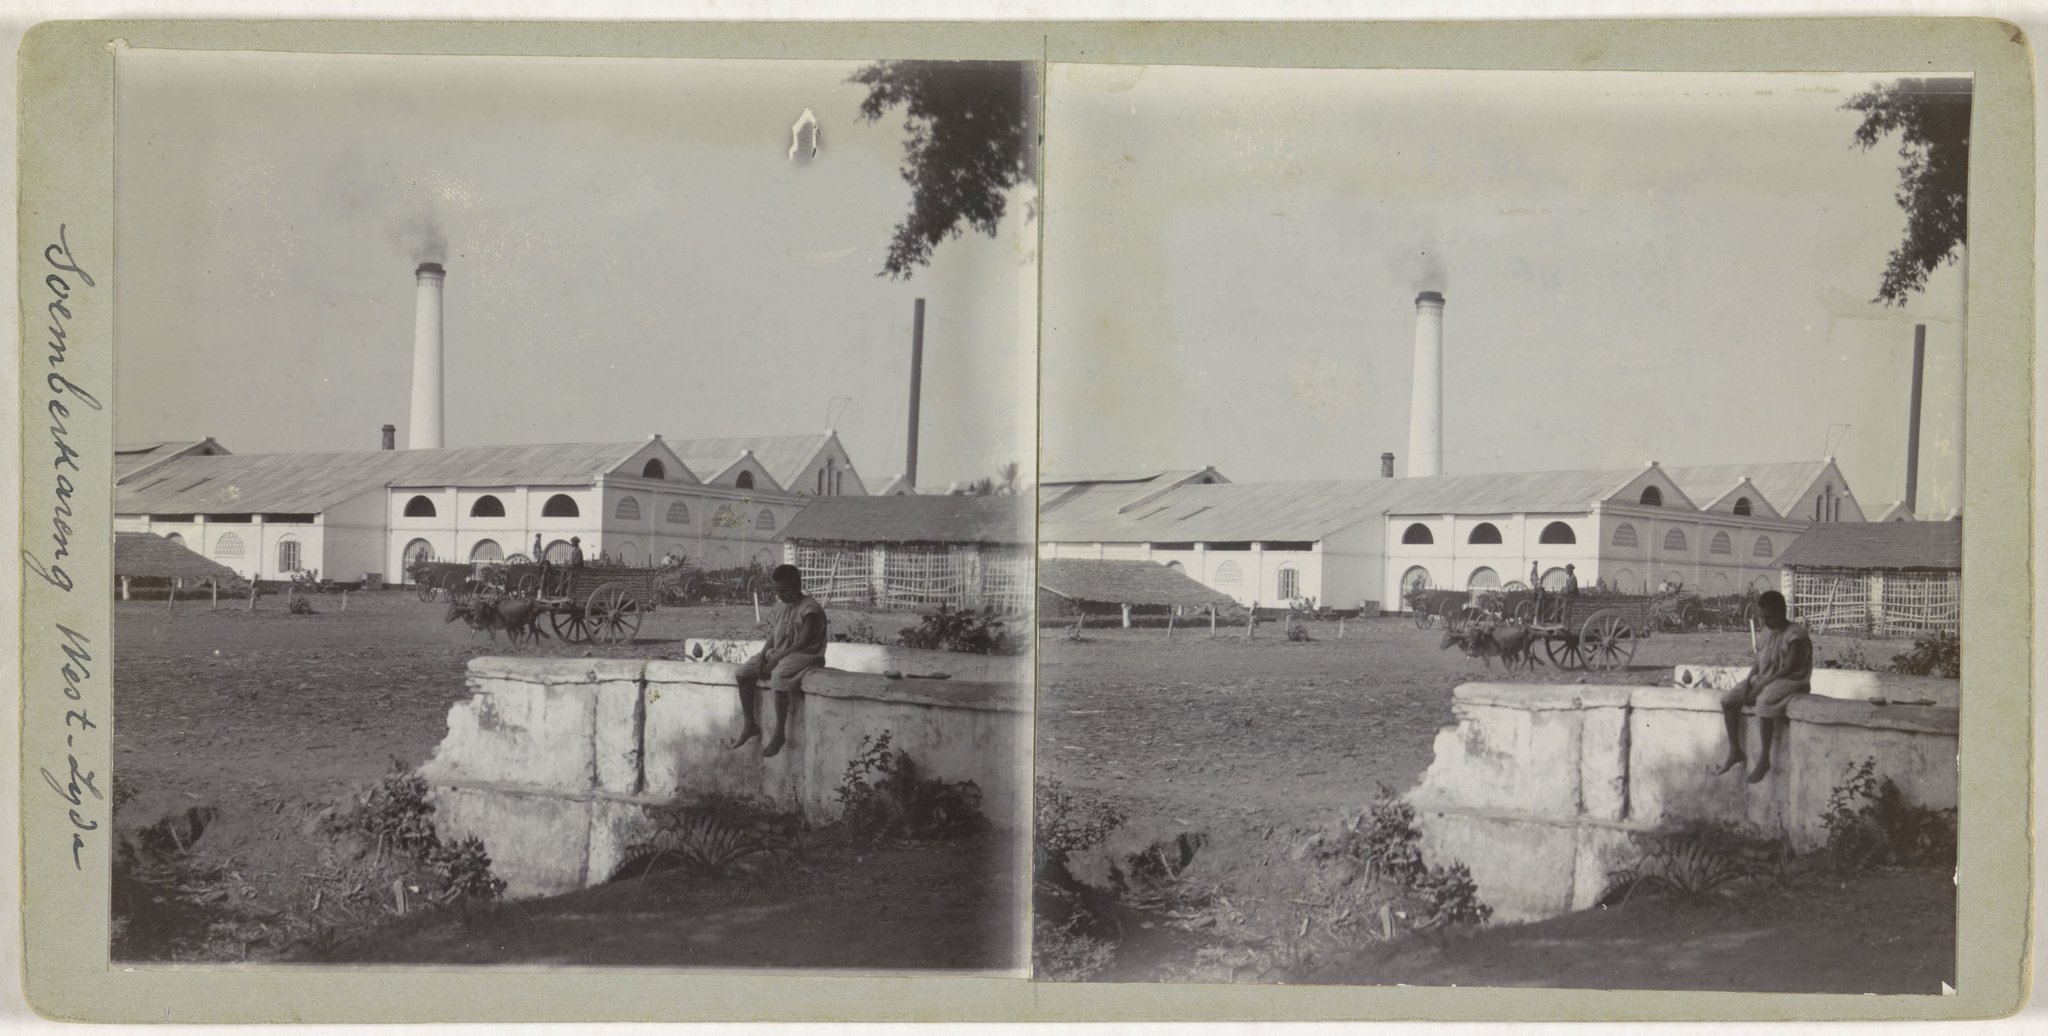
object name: stereograph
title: Westzijde van suikerfabriek (?) Soemberkareng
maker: Anonymous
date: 1906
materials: cardboard, paper, photographic support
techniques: albumen print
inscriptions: title: ‘Soemberkareng West-Zijde’